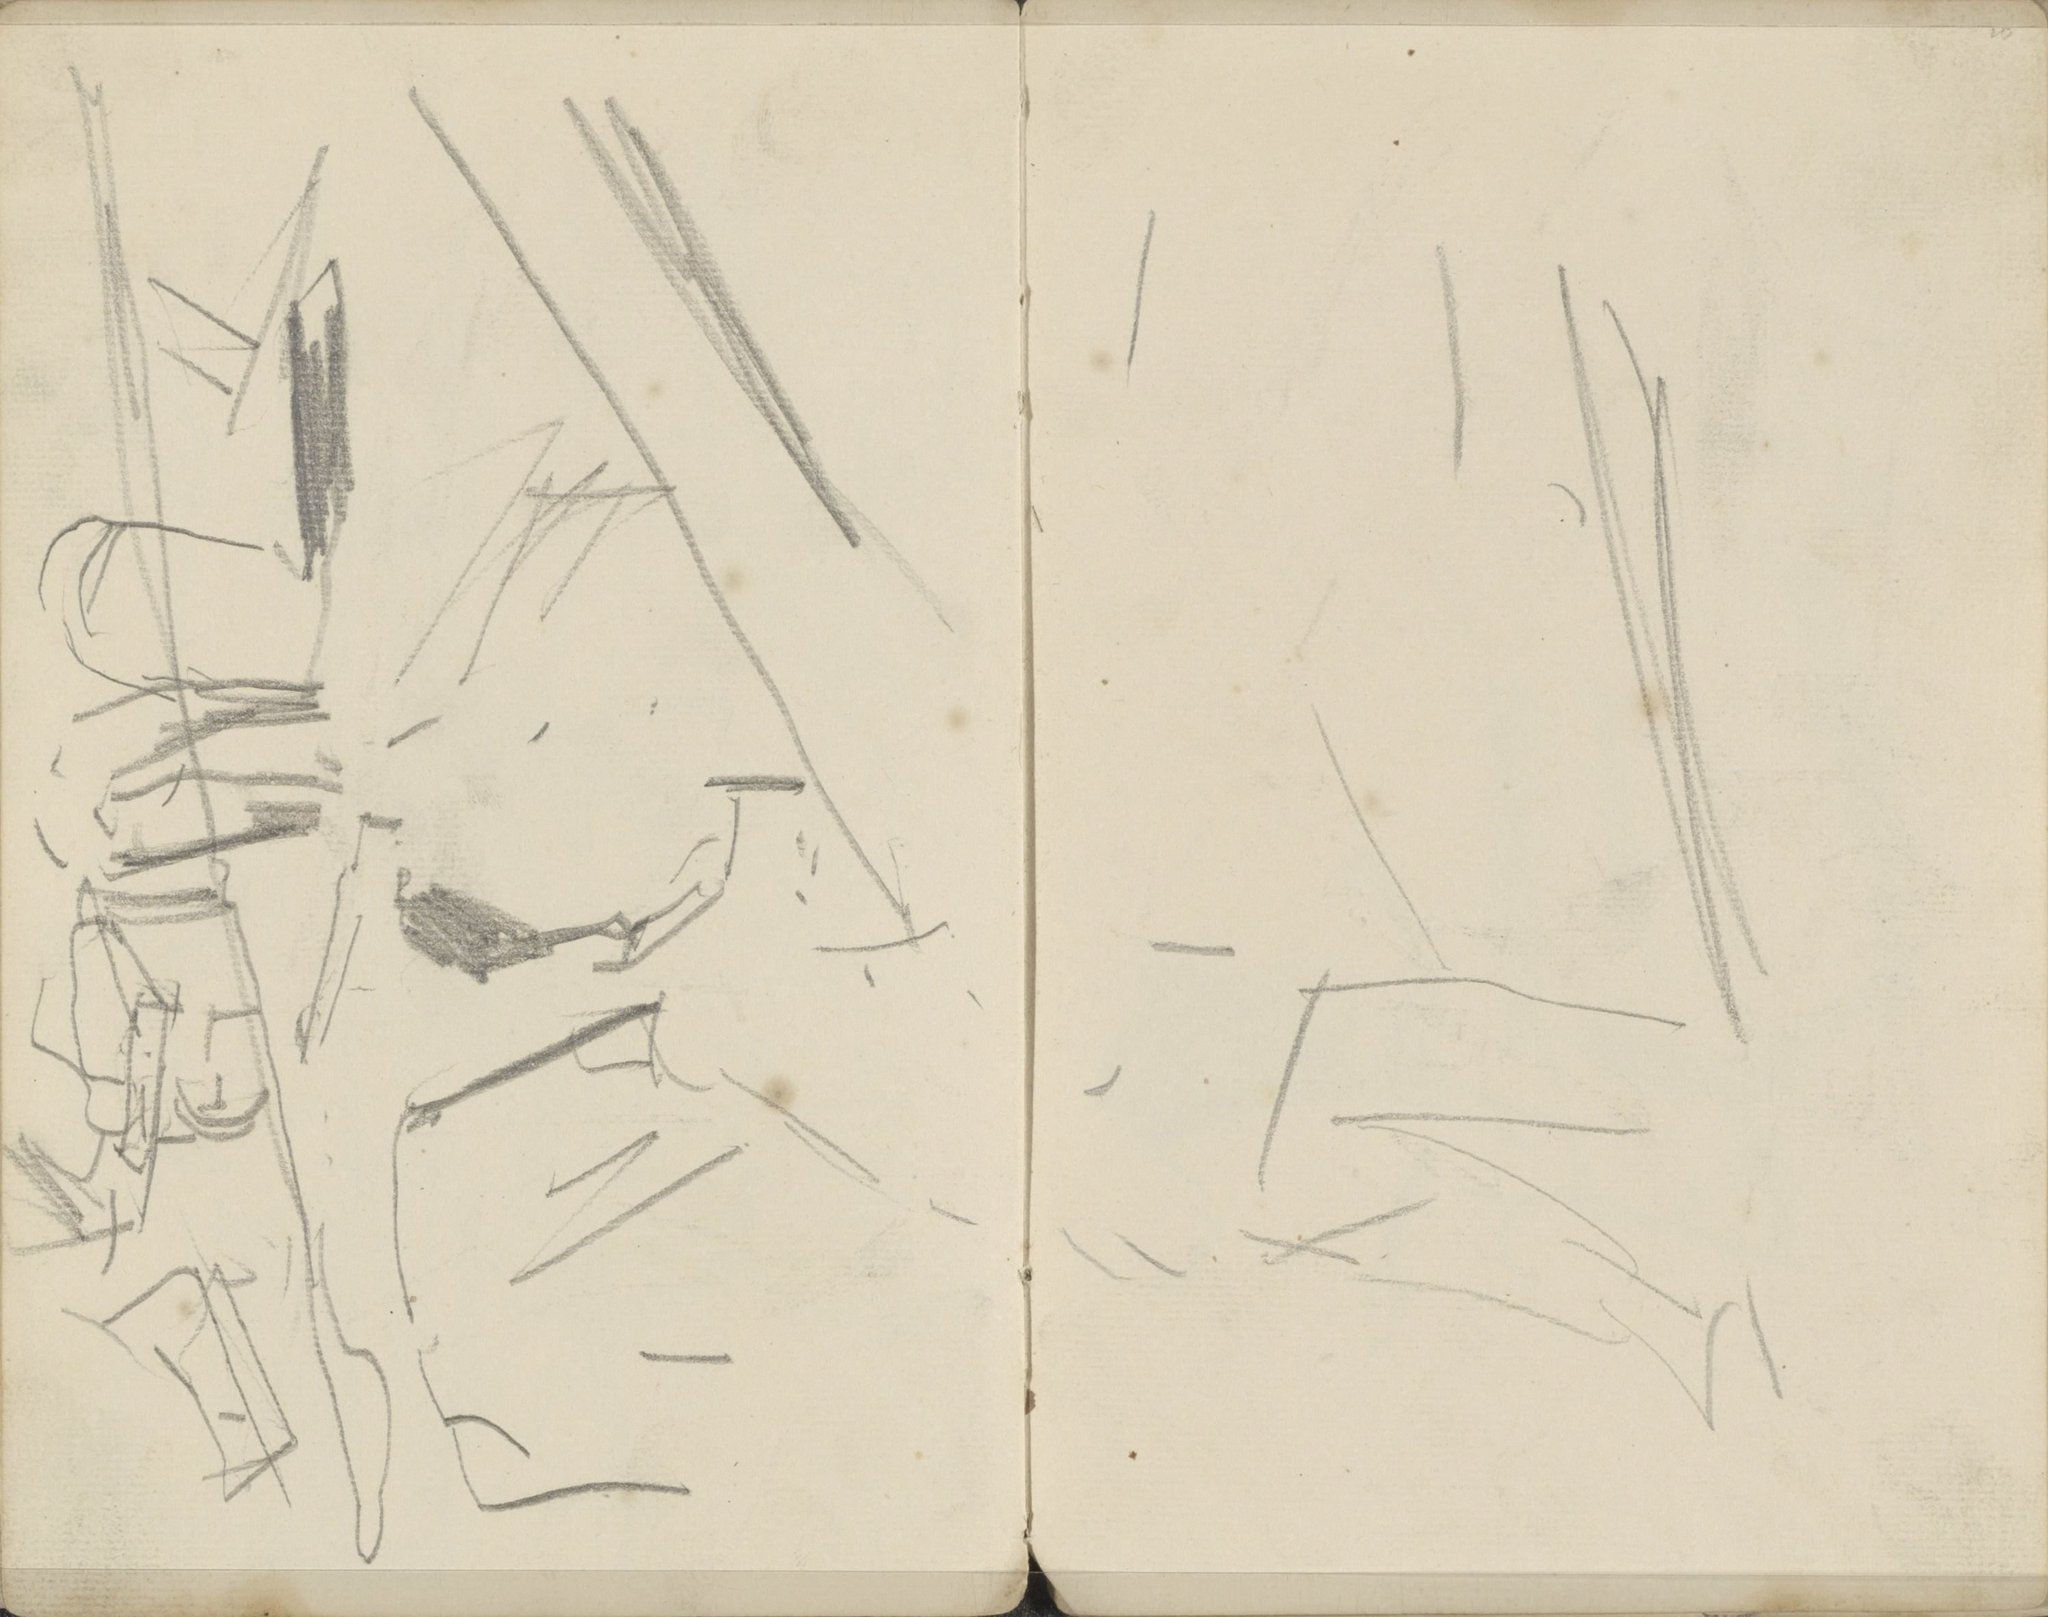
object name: sketchbook leaf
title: Man op een bouwterrein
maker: george hendrik breitner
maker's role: draughtsman, painter, print maker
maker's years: 1857-1923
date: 1886-1923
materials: paper, pencil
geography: amsterdam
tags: adult man, building-site, amsterdam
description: Pagina 9 en pagina 10 uit een schetsboek met 14 bladen.